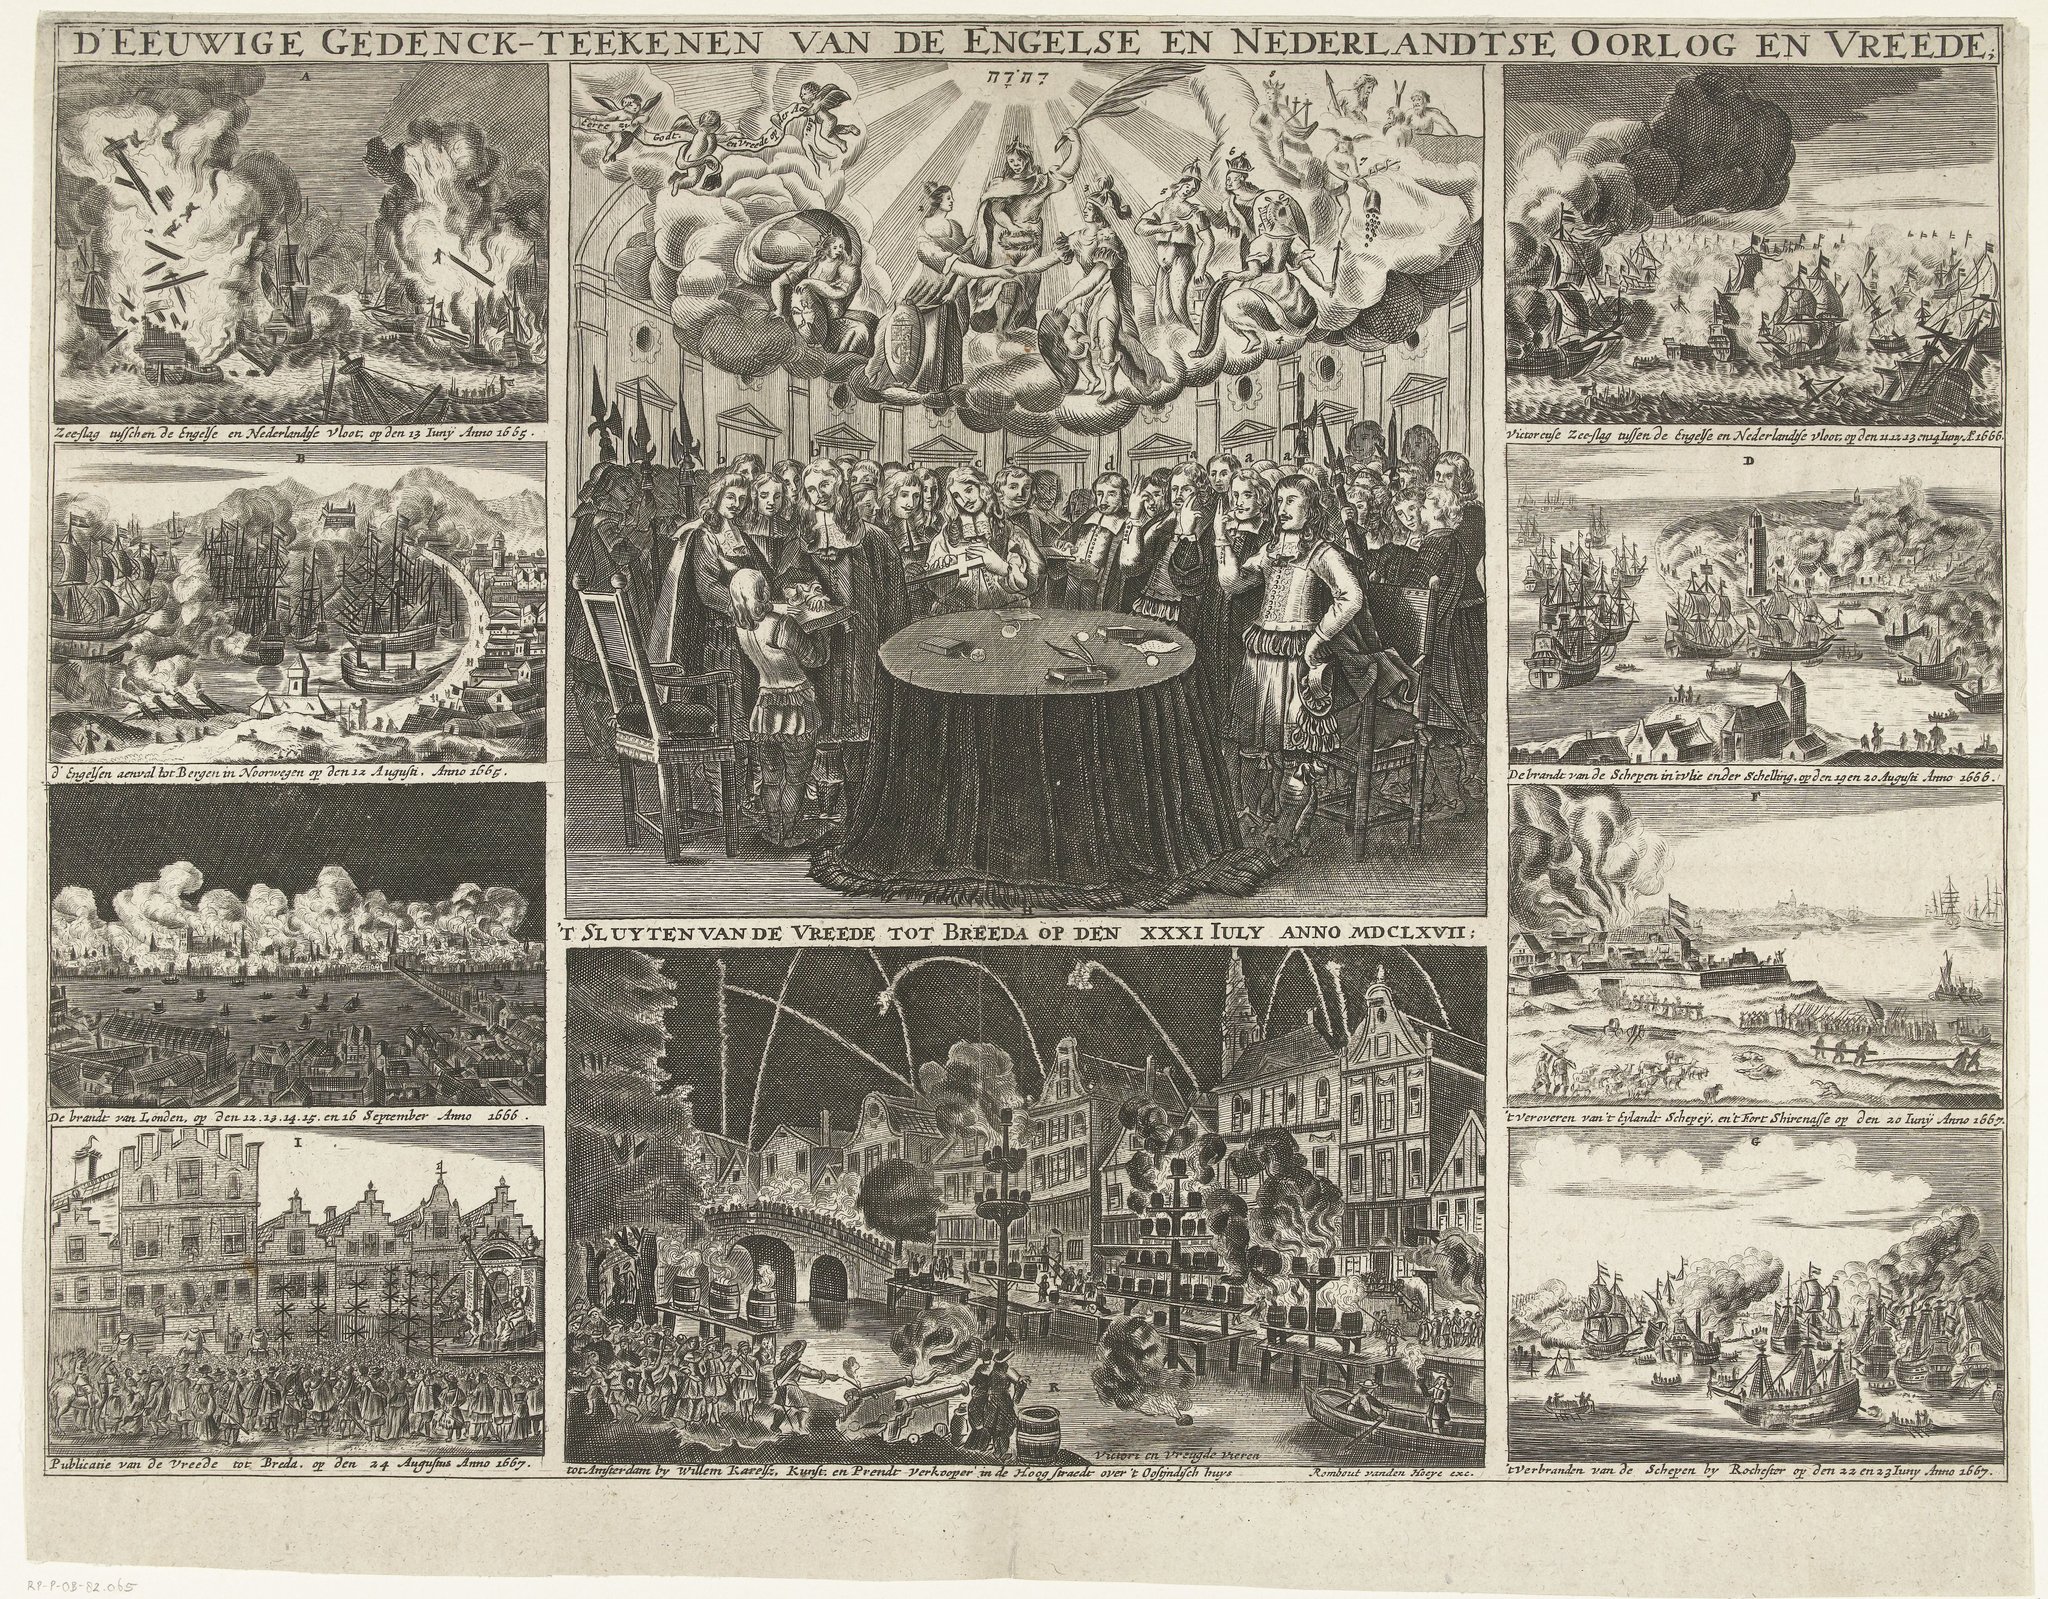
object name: print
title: Vrede van Breda, 1667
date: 1667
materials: paper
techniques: engraving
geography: northern netherlands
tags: battle (+ naval force), proclamation of peace, bonfire, fire-works, signing of peace treaty, concluding the peace, swearing an oath (with two fingers raised), amsterdam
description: De beëdiging van de Vrede van Breda door de Engelse en de Nederlandse gedelegeerden op 31 juli 1667 waarmee een eind kwam aan de Tweede Engelse Oorlog. Centrale voorstelling met het beëdigen van het vredesverdrag. In de wolken geven de Nederlandse en de Engelse maagd elkaar de hand met de Vrede en andere figuren. Hieromheen negen kleine voorstellingen van de zeeslagen uitgevochten tijdens deze oorlog, de bekendmaking van de vrede te Breda op 24 augustus en de vreugdevuren te Amsterdam op 7 september 1667. Alle scènes aangeduid met de letters A-K en voorzien van een onderschrift.